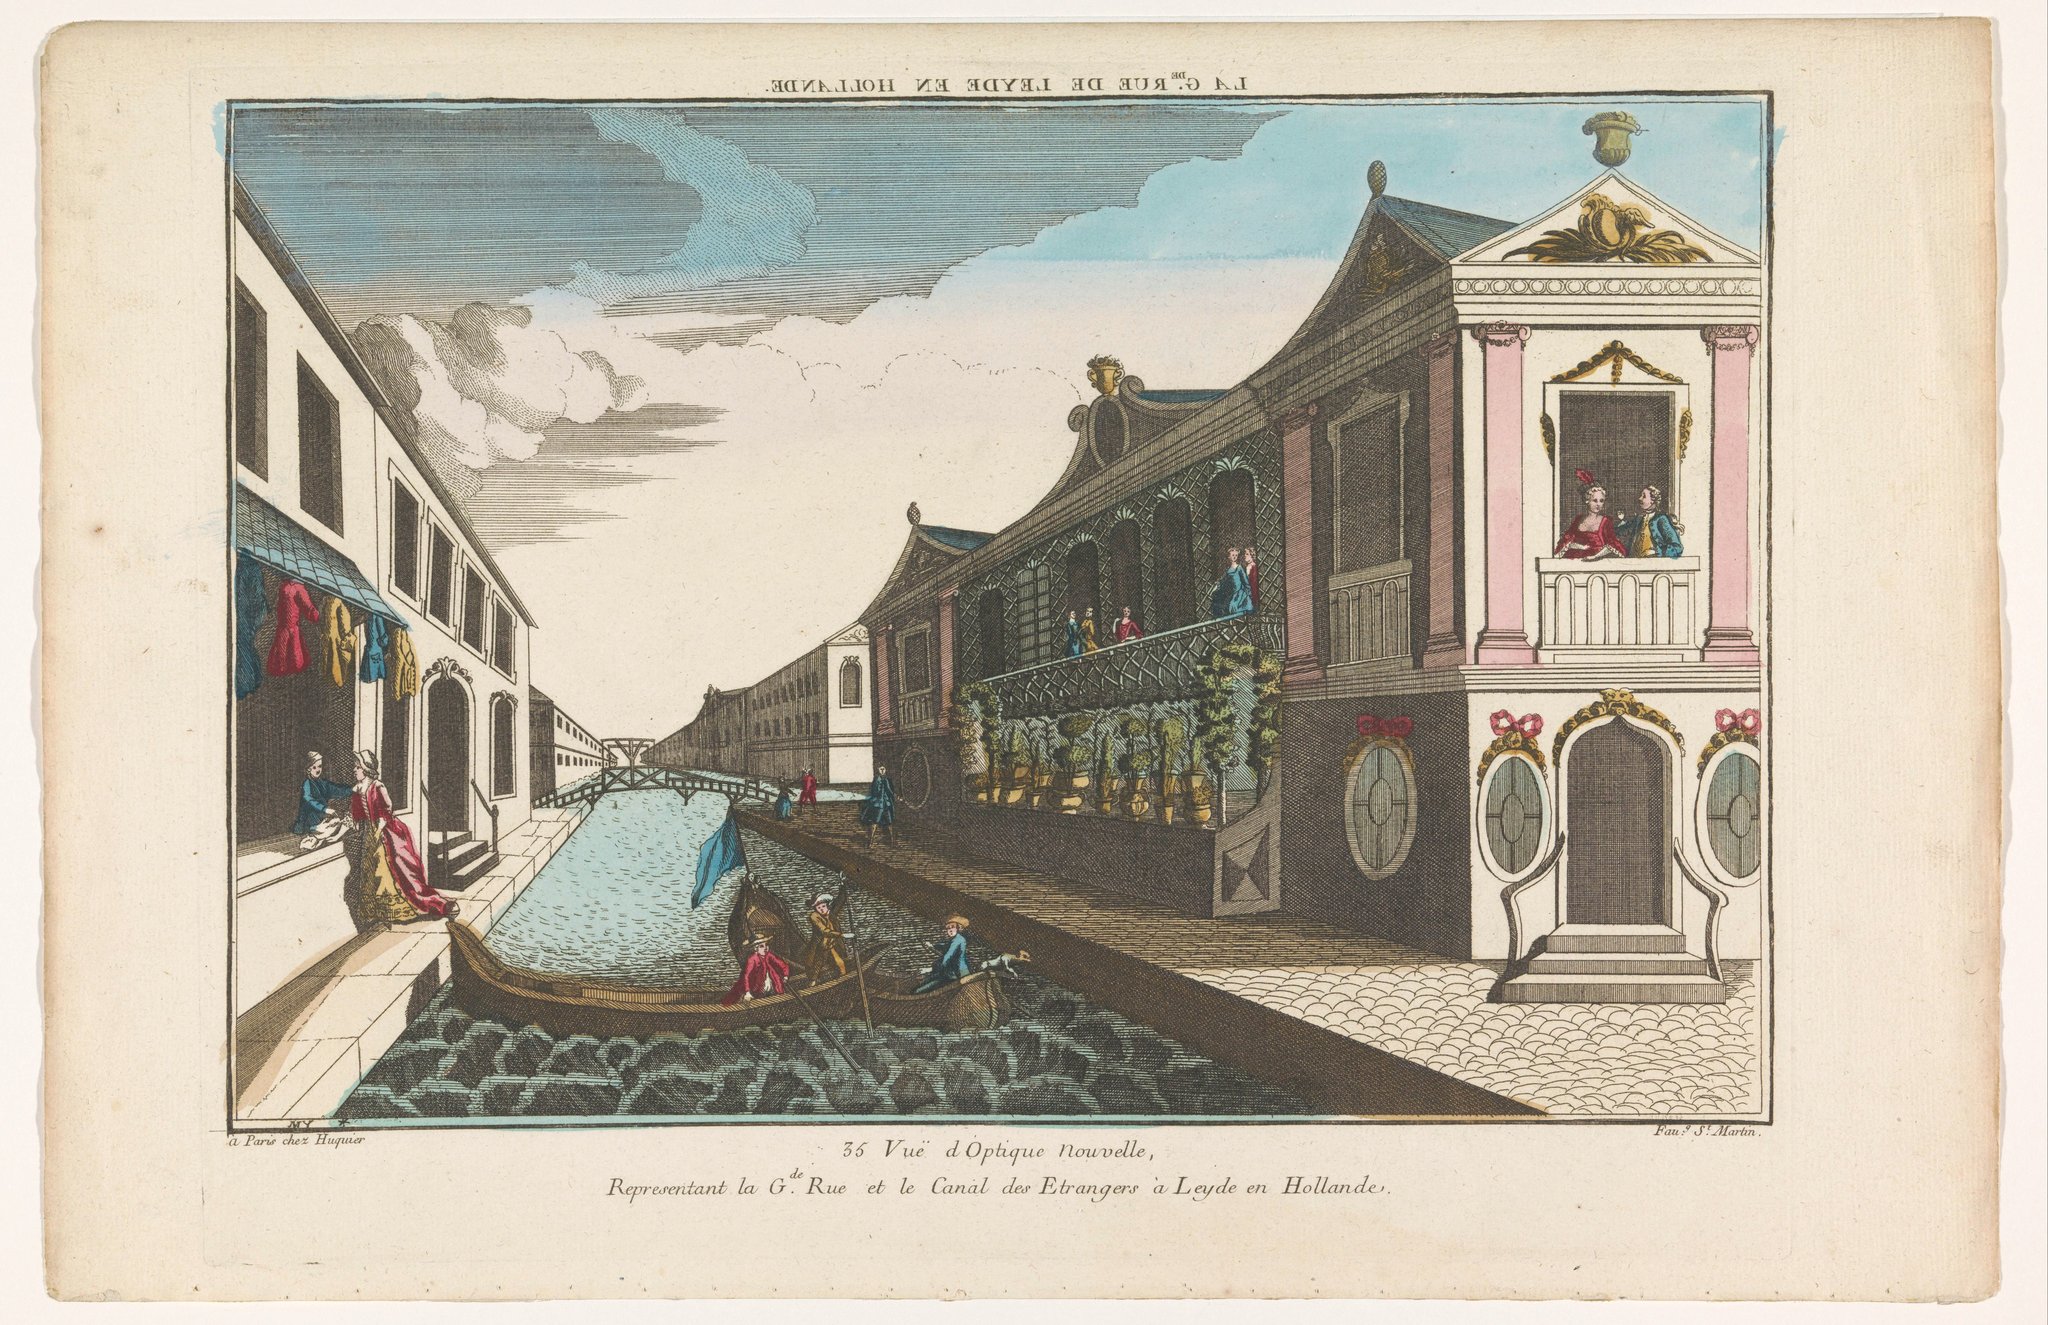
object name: print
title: Gezicht op een straat aan een gracht te Leiden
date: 1735-1805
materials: paper, watercolor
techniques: brush, etching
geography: france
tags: bridge in city across river, canal, etc. (+ city(-scape) with figures, staffage), stall, booth (~ market), rowing-boat, canoe, etc., canals, waters (in city) (+ city(-scape) with figures, staffage), street (+ city(-scape) with figures, staffage), leiden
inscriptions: collector's mark: Lugt 2166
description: Links en rechts kramen met uitgestalde koopwaren. Op de gracht twee roeiboten met figuren. Genummerd: 35.